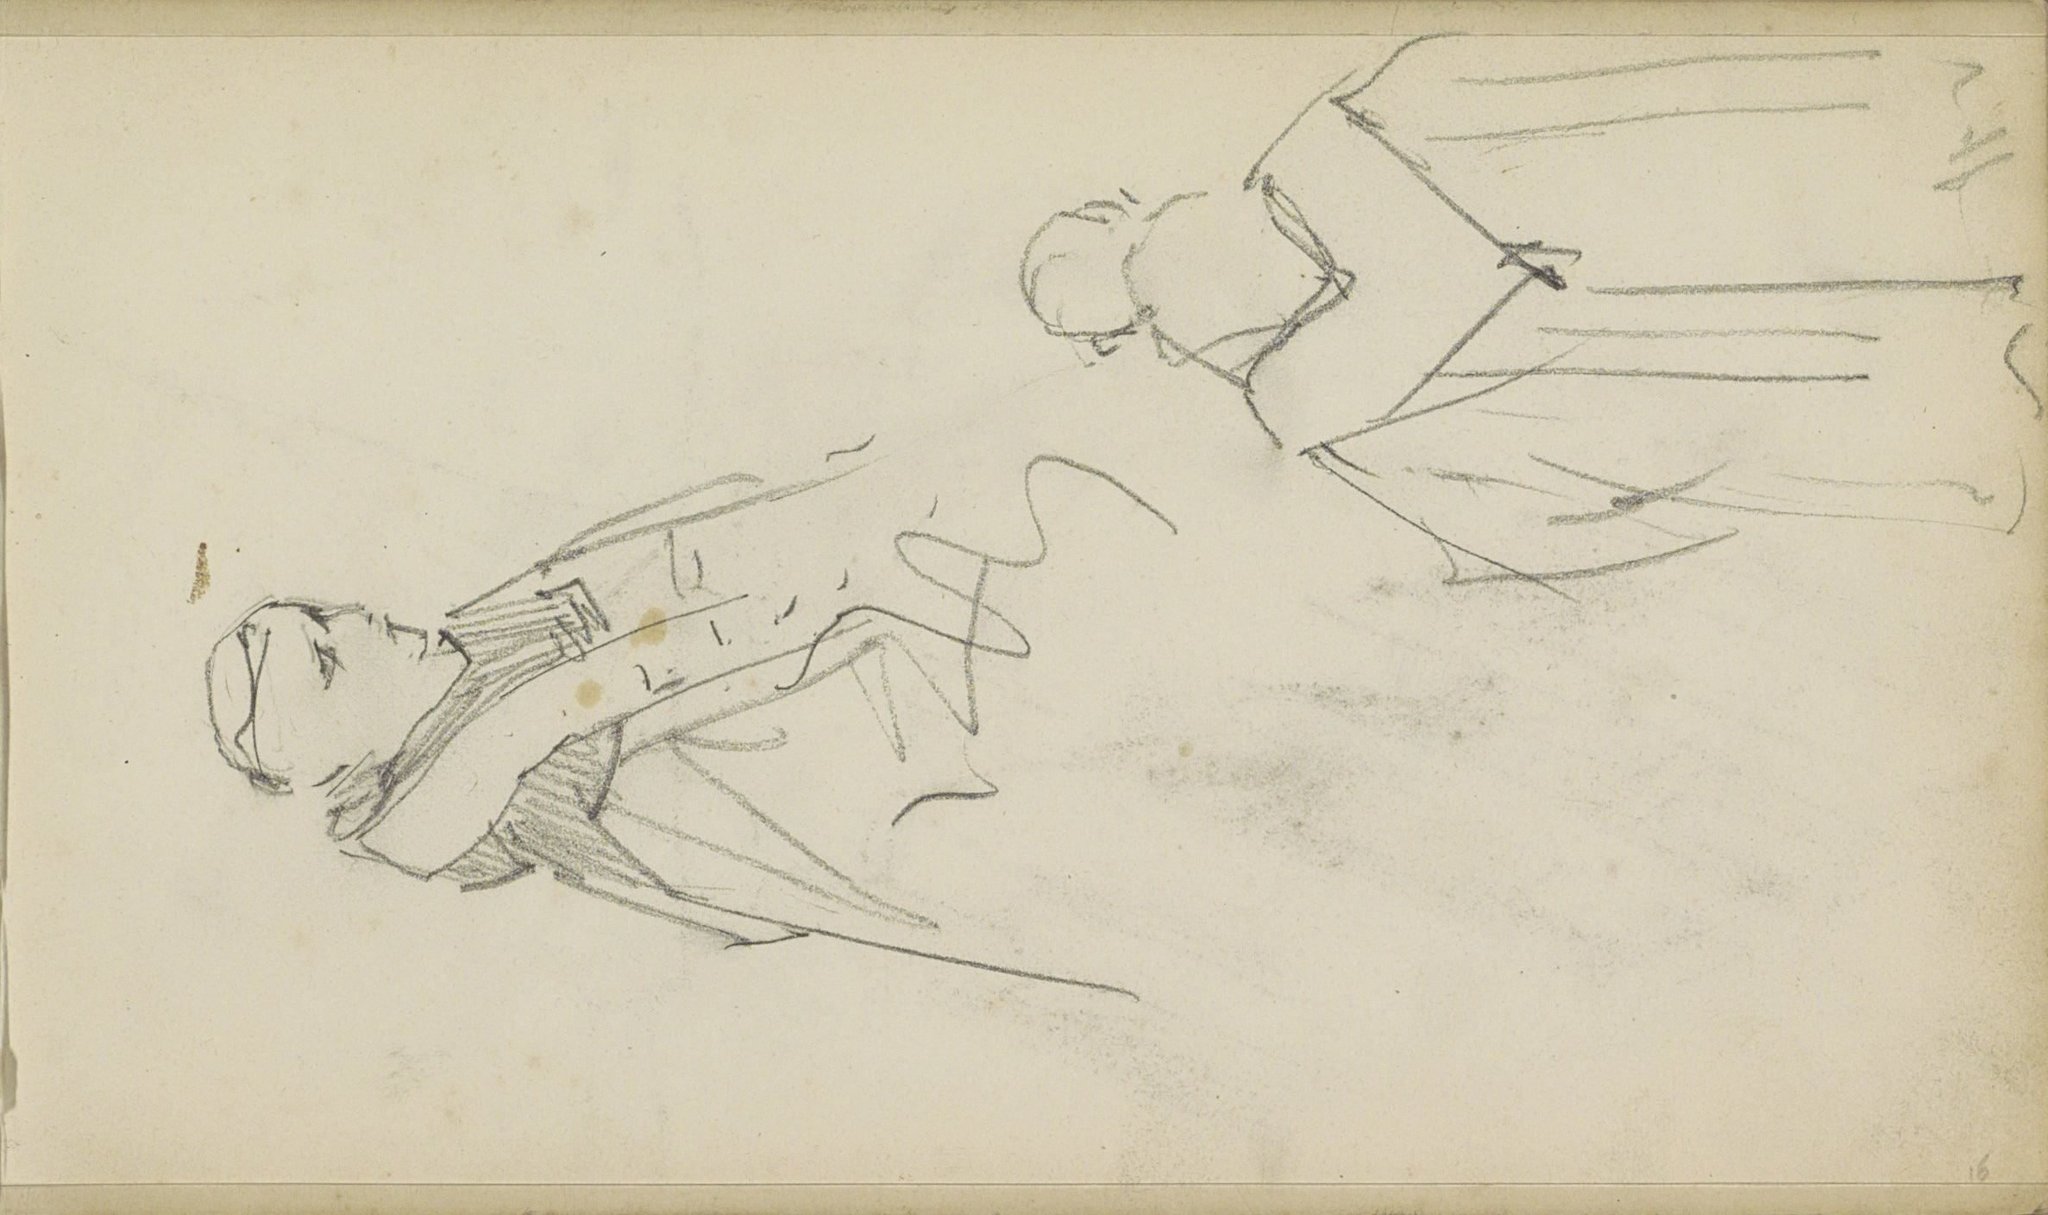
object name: sketchbook leaf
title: Monnik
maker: johannes bosboom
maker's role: draughtsman, painter, print maker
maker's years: 1817-1891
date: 1845-1891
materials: paper, pencil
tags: monk(s), friar(s)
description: Blad 16 recto uit een schetsboek met 46 bladen.